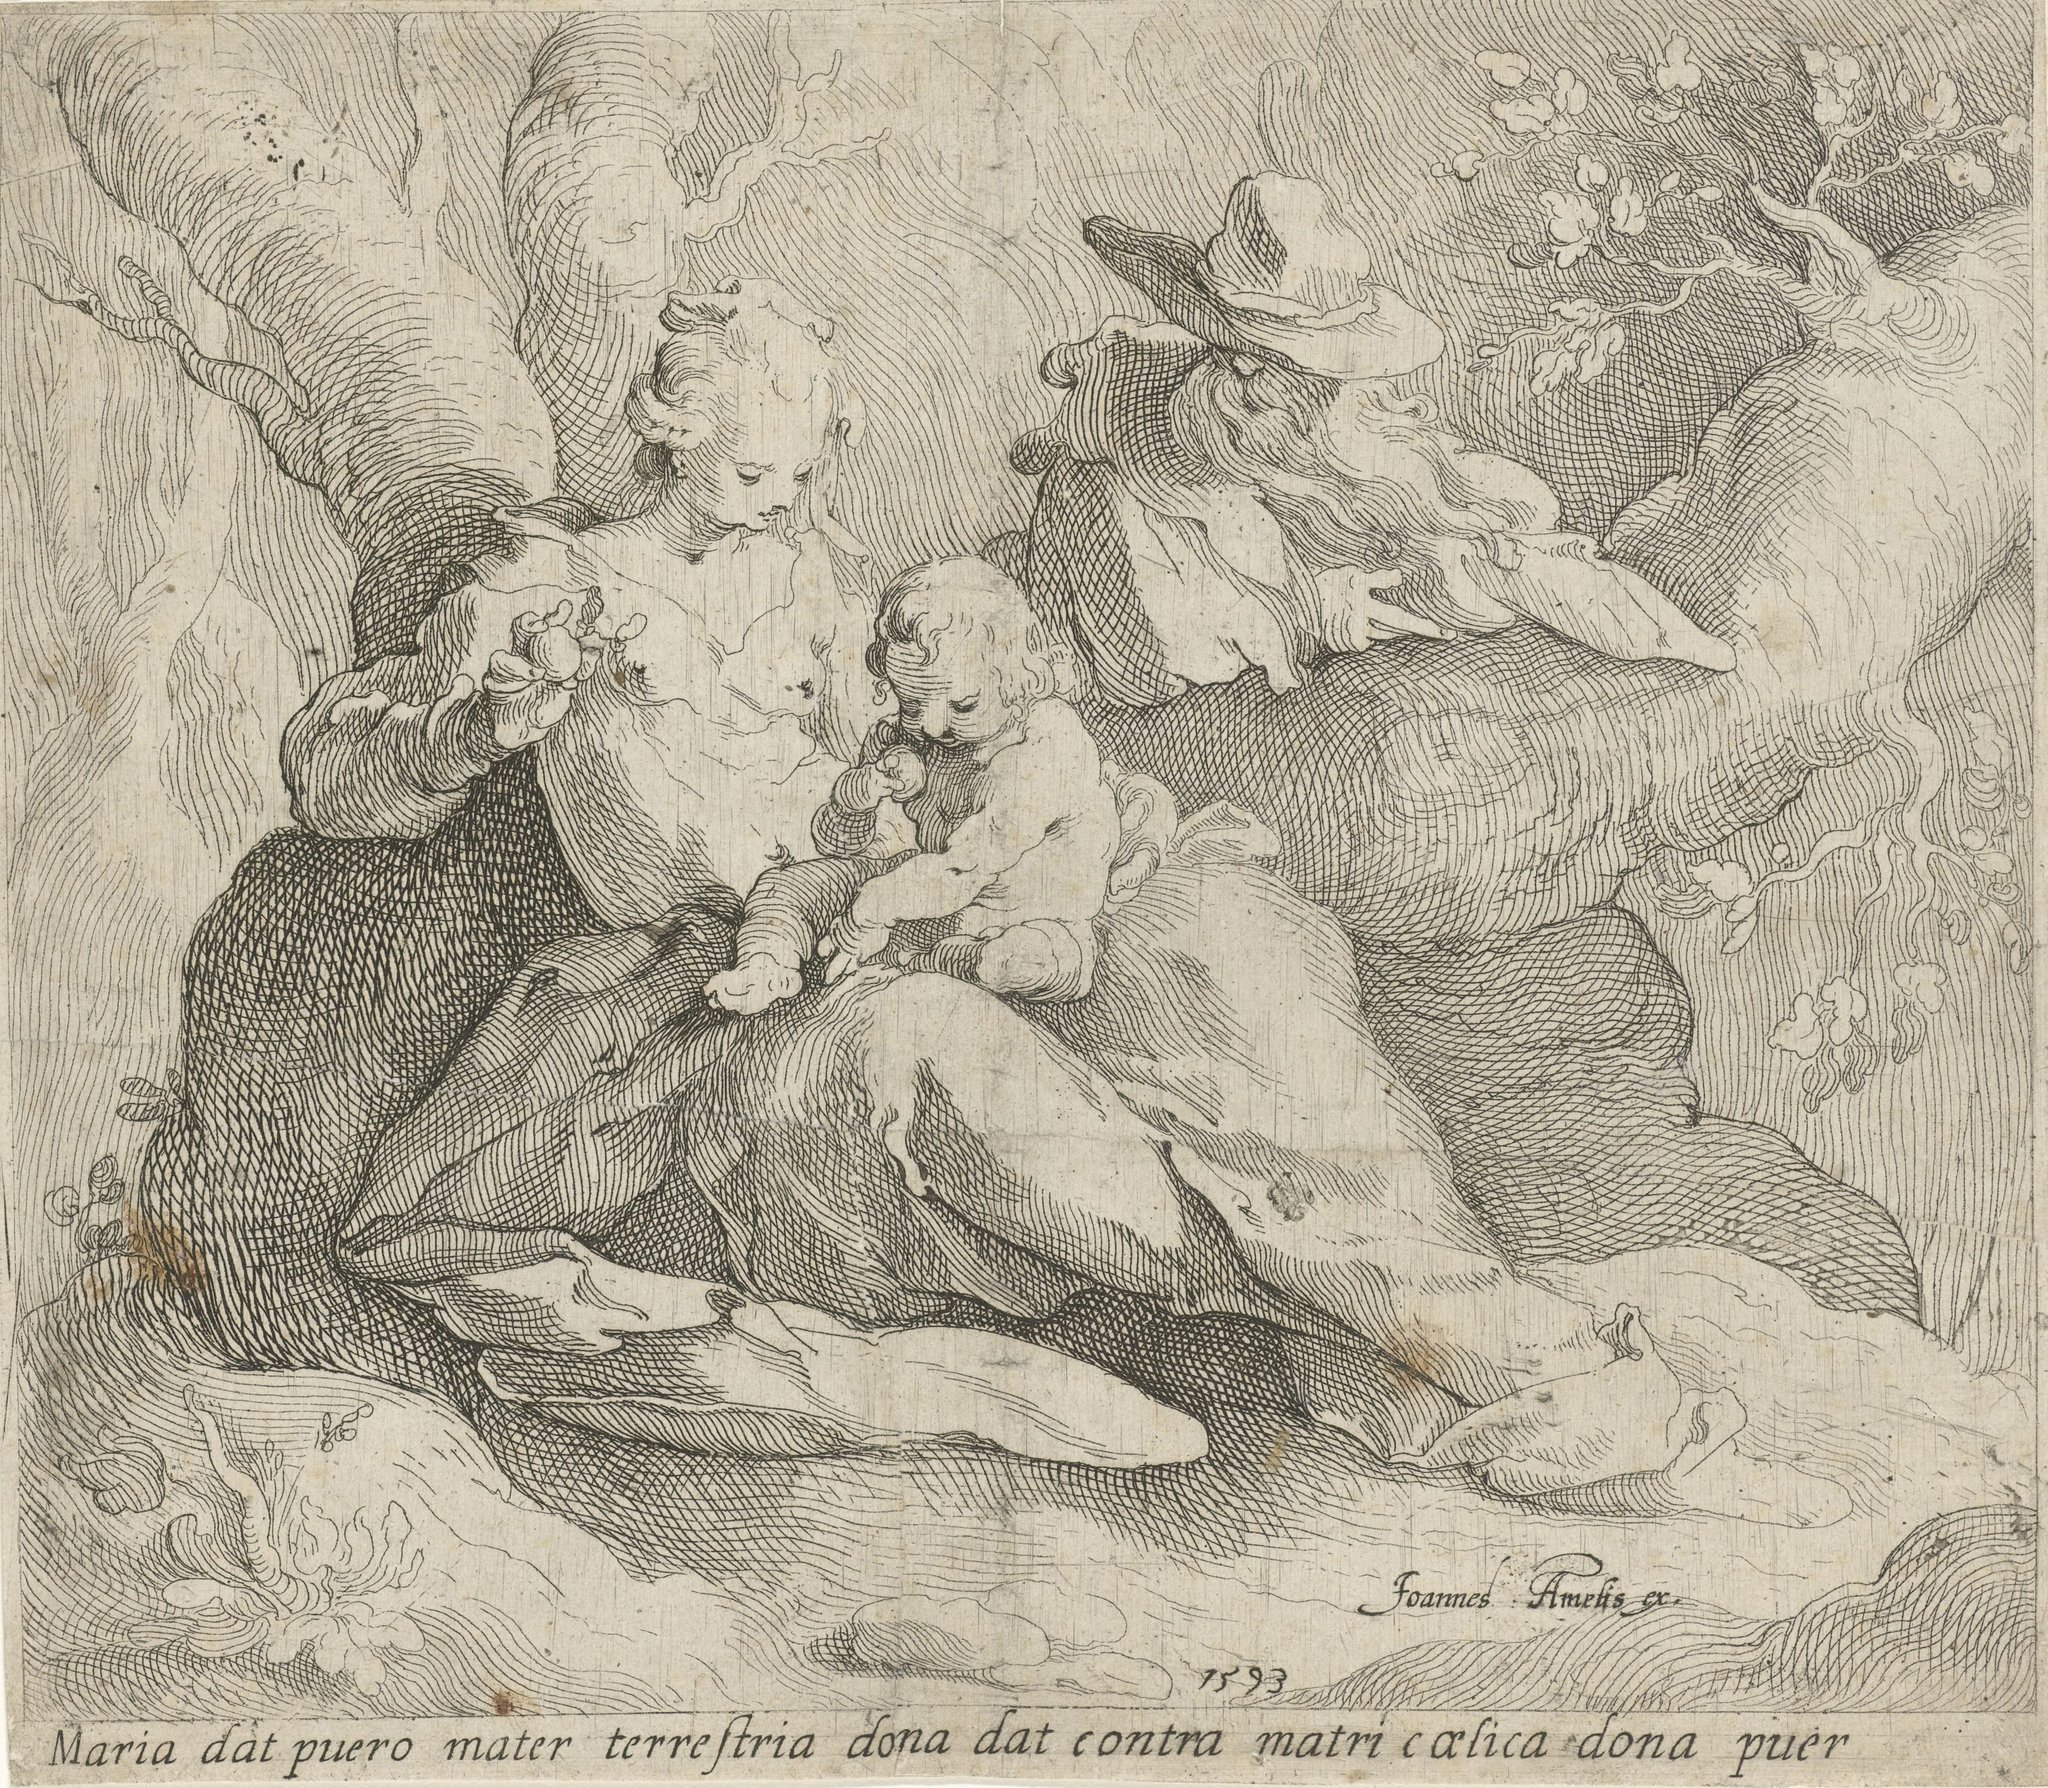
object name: print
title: Heilige Familie met de appel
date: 1593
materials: paper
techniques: etching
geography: amsterdam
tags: fruits: apple, holy family, and derived representations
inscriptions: inscription: ‘Spranger’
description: Landschap met de Heilige Familie. Het Christuskind zit op schoot bij zijn moeder Maria. Jozef leunt tegen een boomstam en kijkt toe hoe zij een appel eten. In de marge een onderschrift in het Latijn.